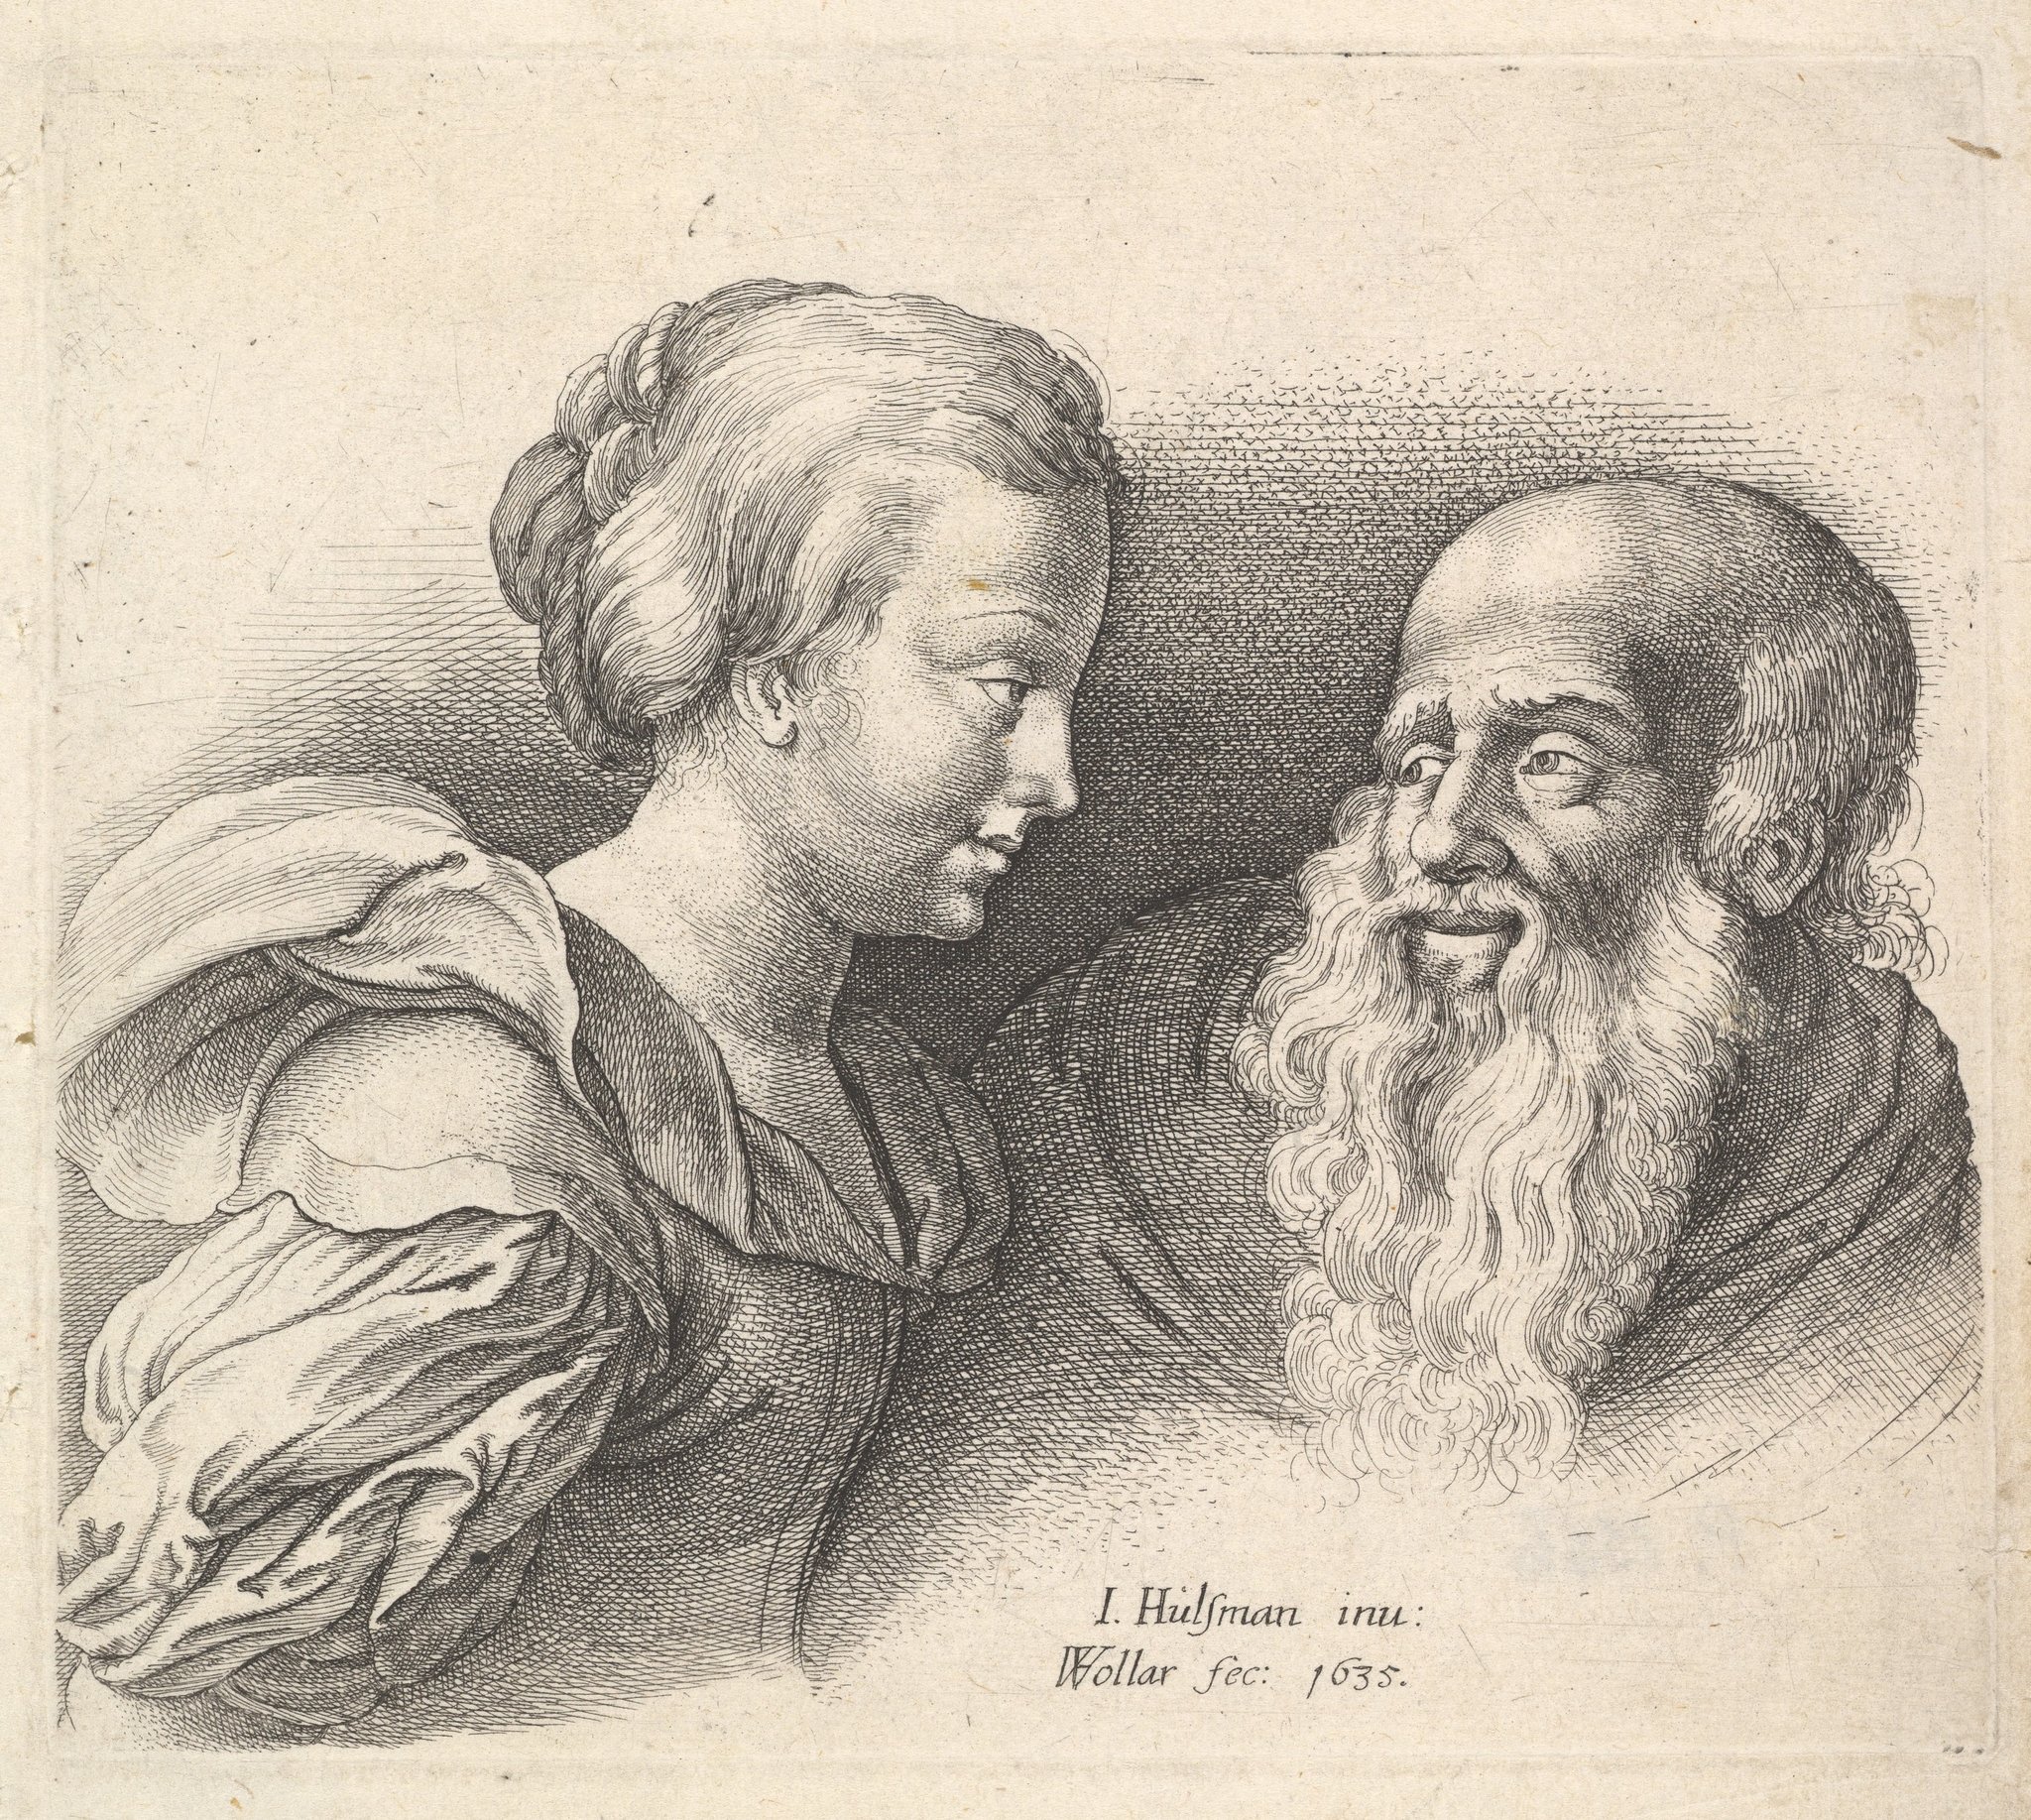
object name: print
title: An Old Man and a Girl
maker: wenceslaus hollar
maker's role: artist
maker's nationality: bohemian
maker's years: 1607-1677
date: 1635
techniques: etching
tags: girls,men,profiles